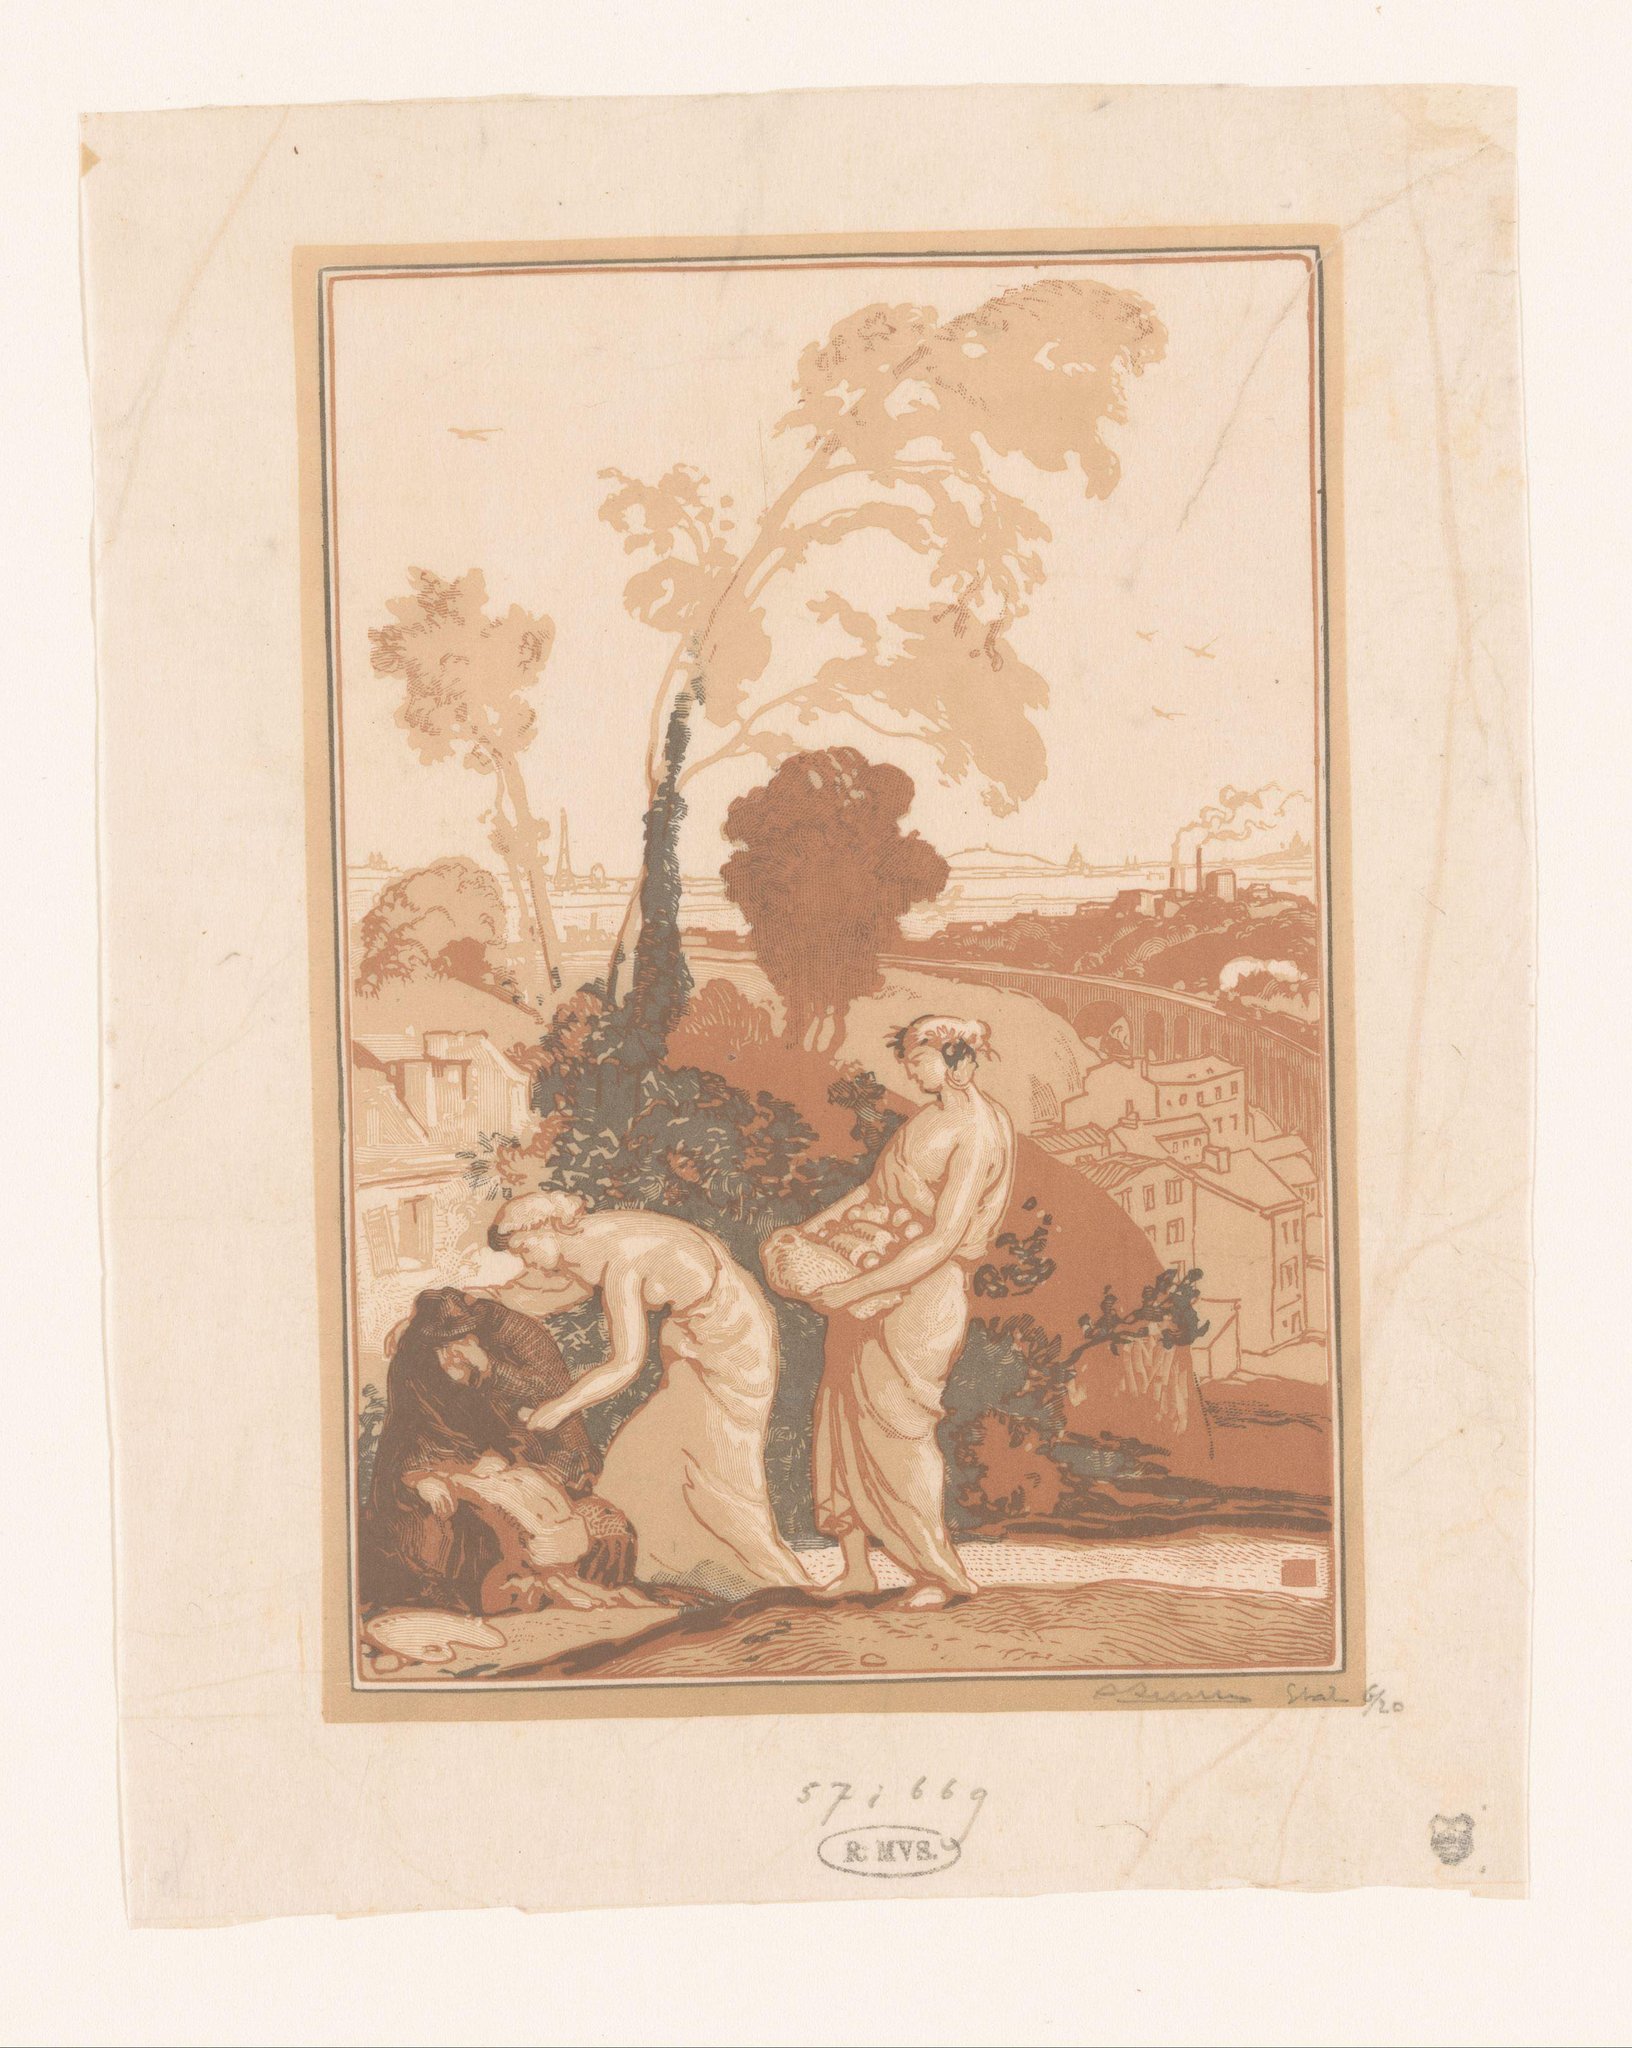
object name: print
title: La Musique et la Poesie secourant les Artistes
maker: auguste lepère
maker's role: print maker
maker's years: 1849-1918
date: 1909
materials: paper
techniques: woodcut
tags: 'musica', symbolic representations, allegories and emblems ~ music; 'musica'(ripa), symbolic representations, allegories and emblems ~ poetry; 'poesia' (ripa), artist (in general)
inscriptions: collector's mark: Lugt 2228, collector's mark: Lugt 2760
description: Landschap met de personificaties van muziek en poëzie die een treurende kunstenaar helpen.